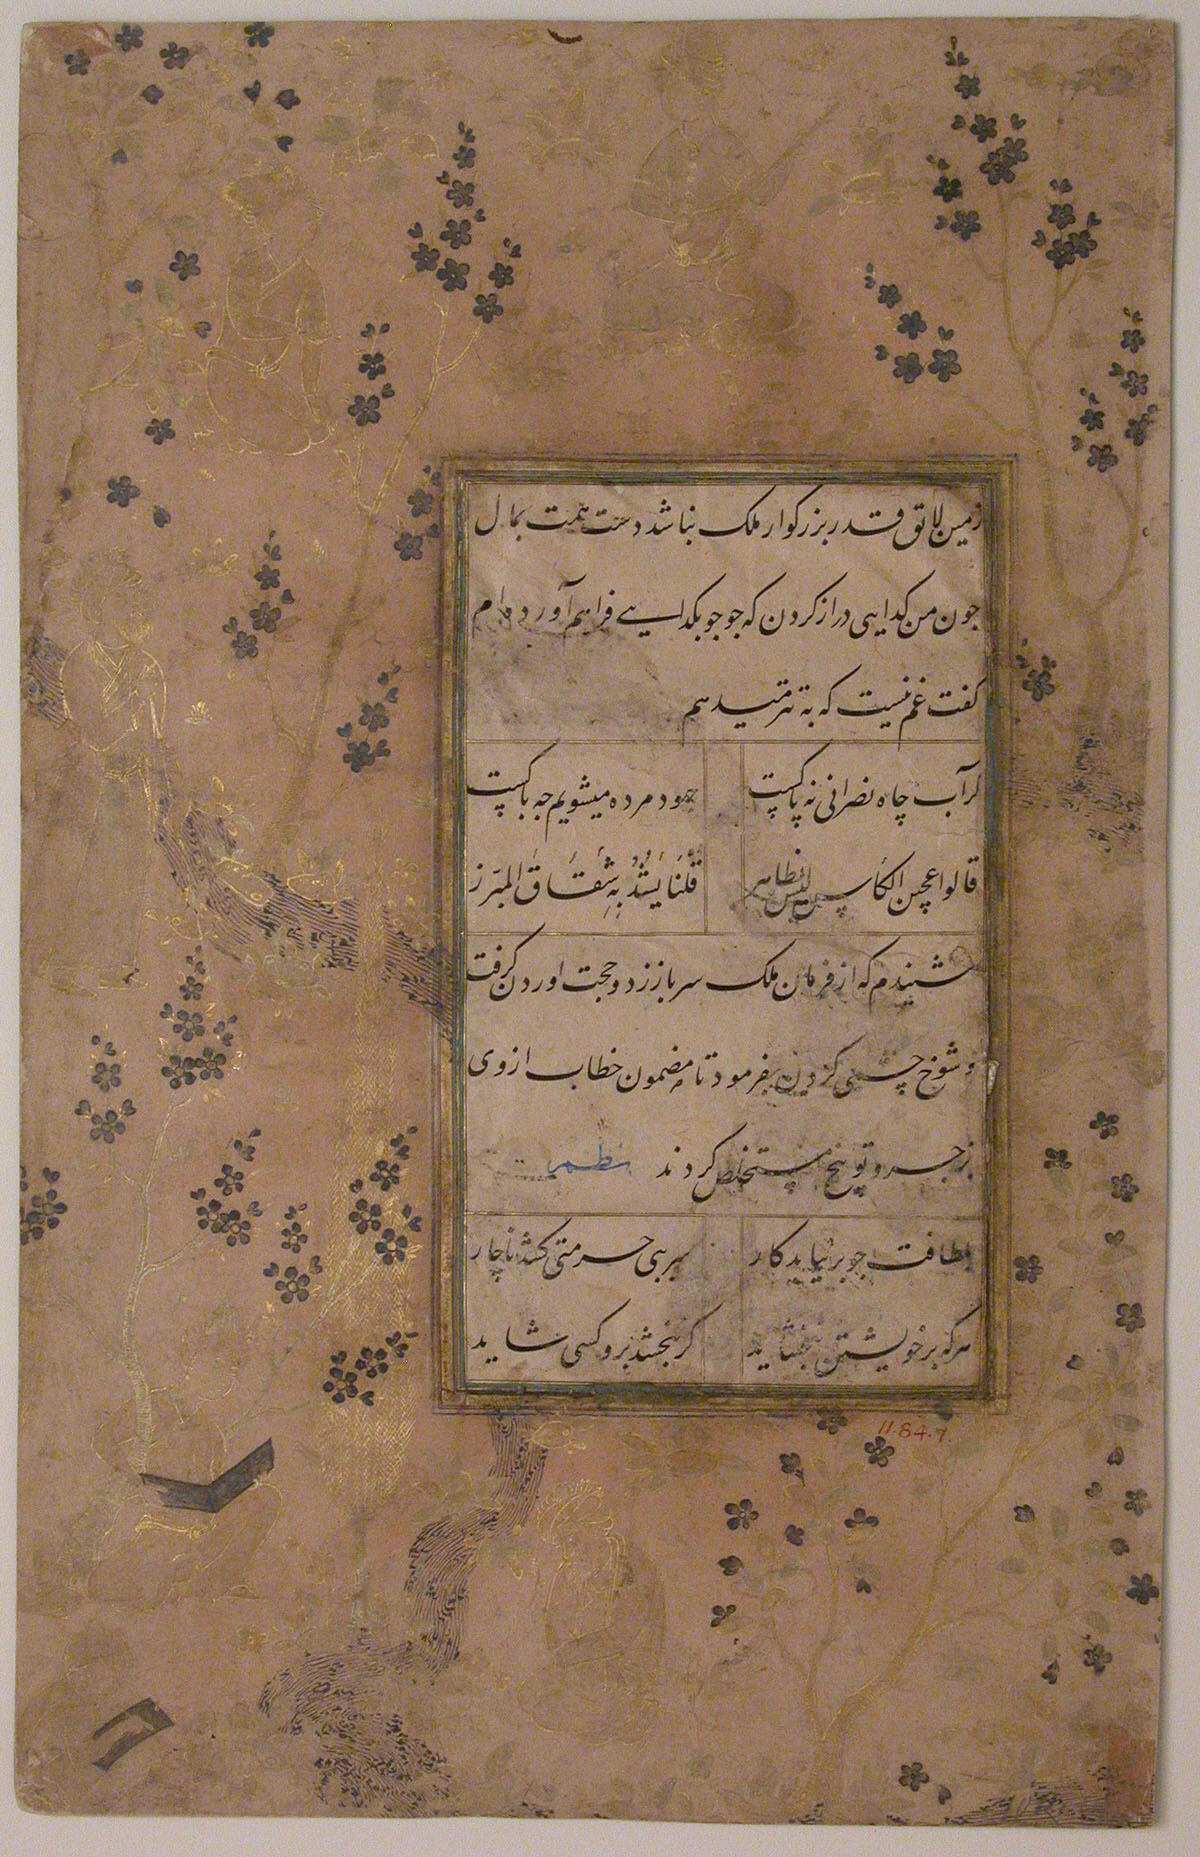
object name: folio from a non illustrated manuscript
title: Page of Calligraphy from an Anthology of Poetry by Sa`di and Hafiz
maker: sa'di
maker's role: author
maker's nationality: iranian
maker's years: 1213-1291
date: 1467-1500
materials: gold, ink, paper, silver, watercolor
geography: afghanistan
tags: poetry,calligraphy